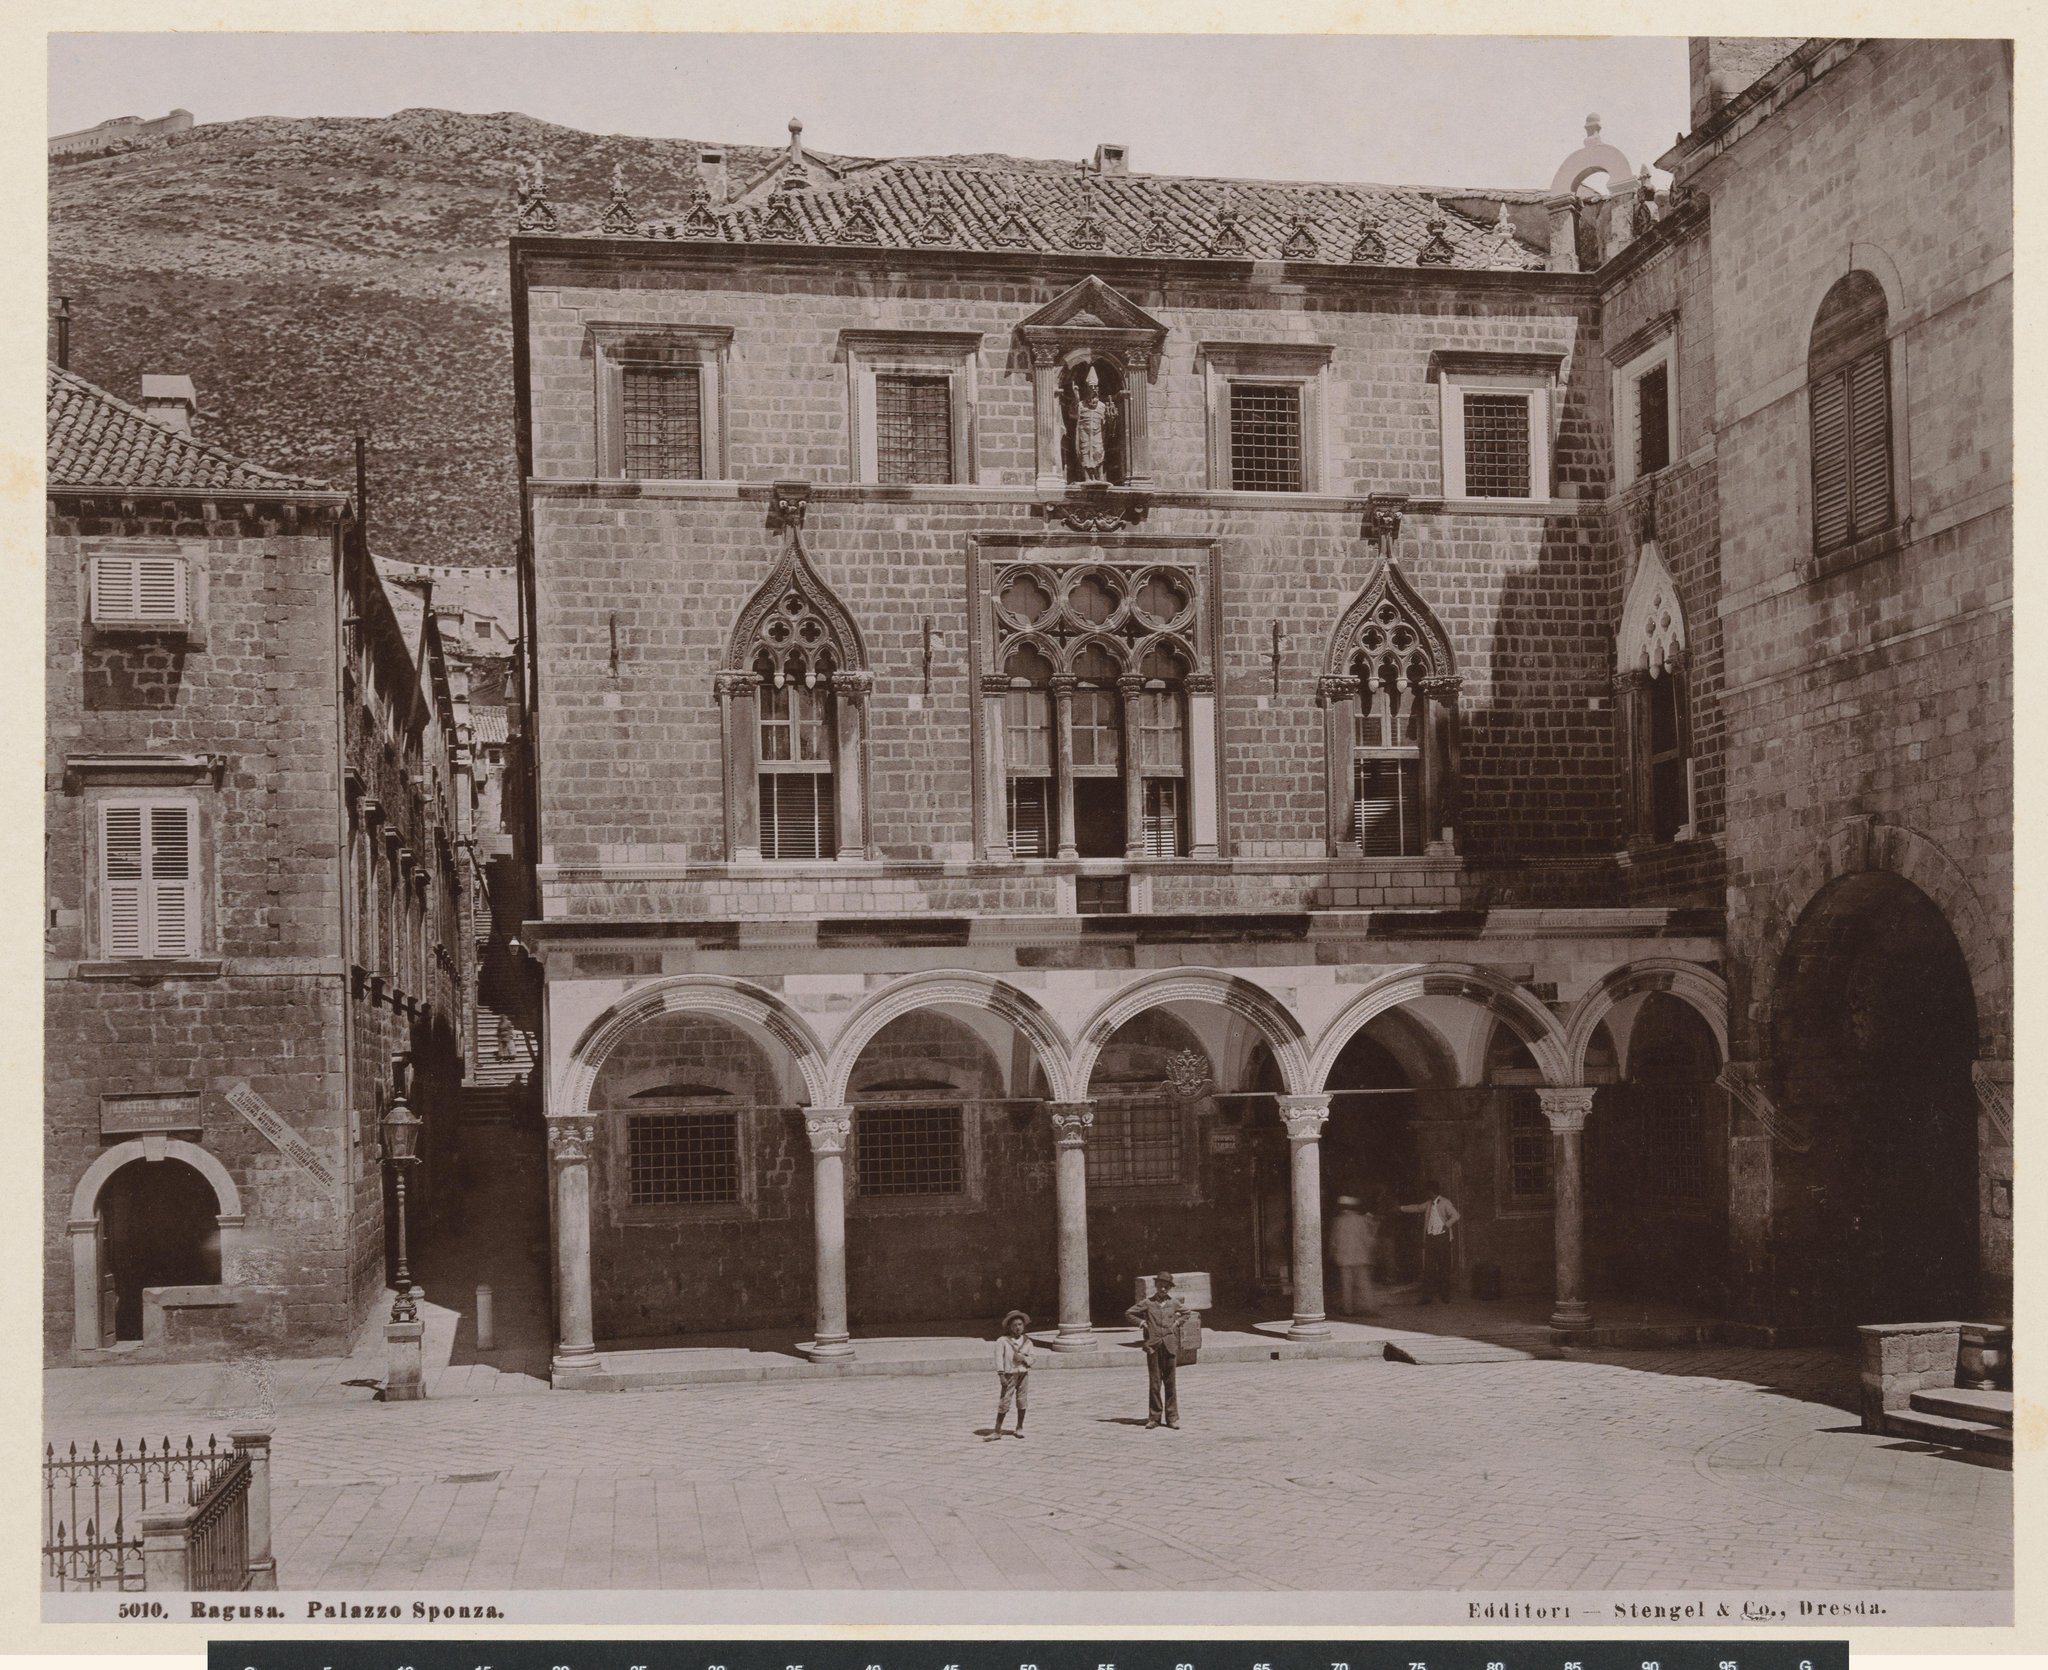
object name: photomechanical print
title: Palazzo Sponza te Dubrovnik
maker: Anonymous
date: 1889-1910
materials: cardboard, paper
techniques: photograph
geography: dubrovnik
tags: palace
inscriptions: title: ‘5010. Ragusa. Palazzo Sponza. Edditori - Stengel & Co., Dresda.’, collector's mark: Lugt 2228